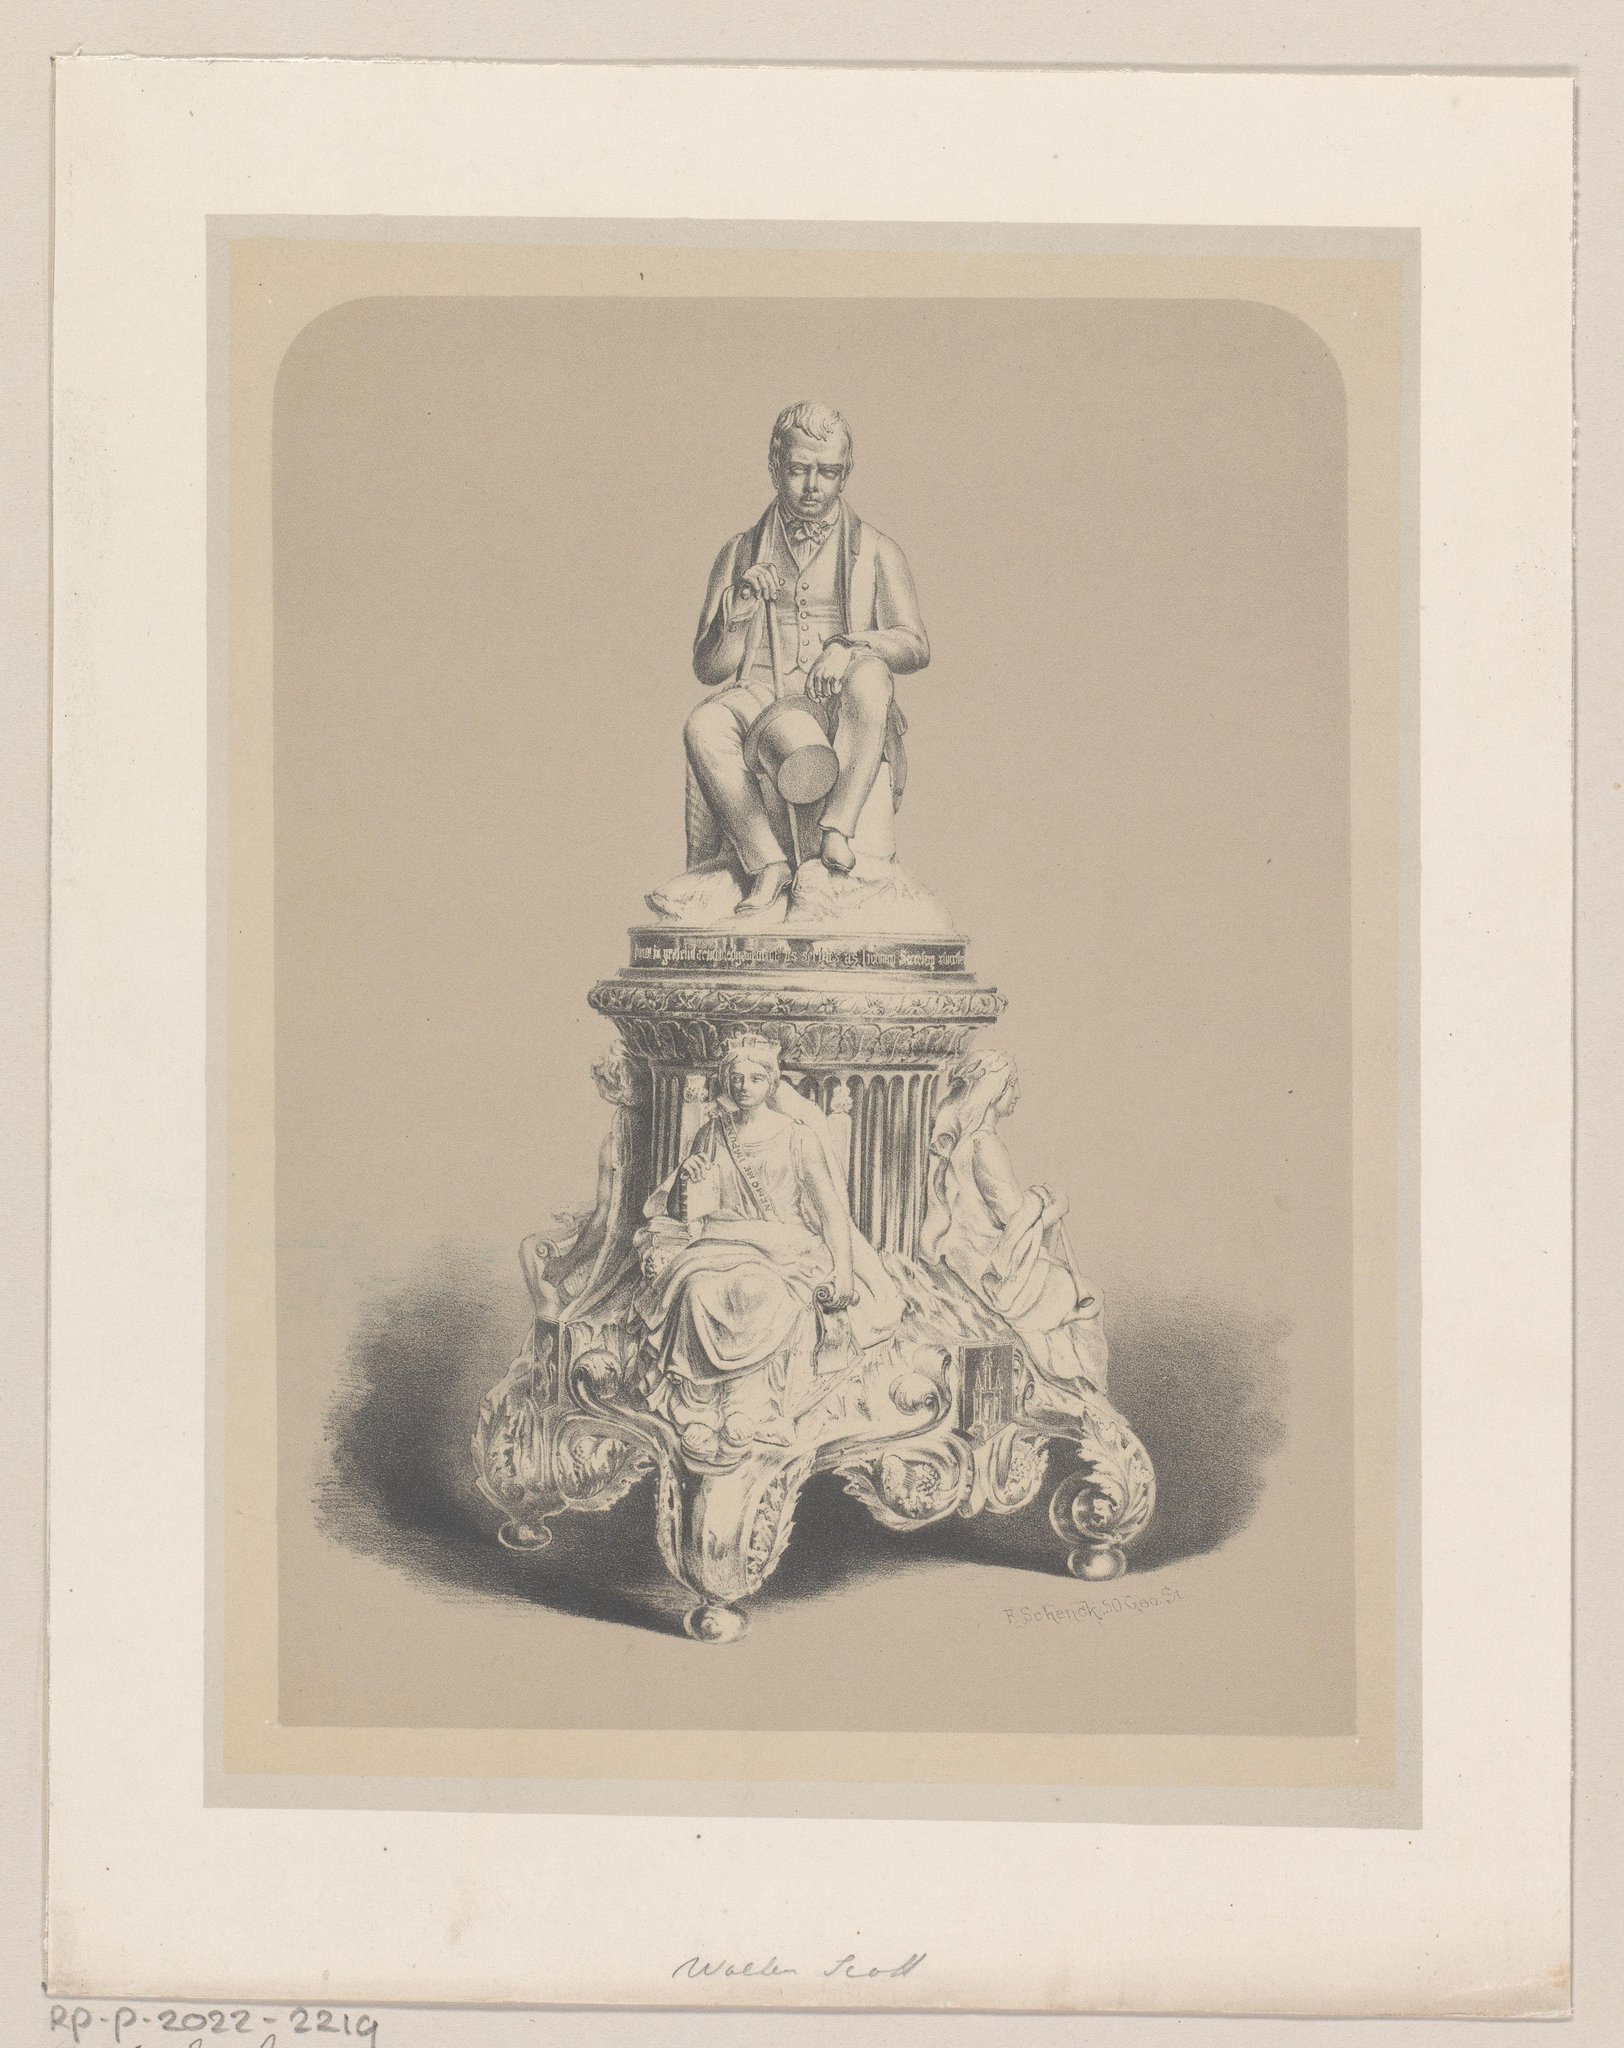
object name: print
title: Sculptuur van Walter Scott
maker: Anonymous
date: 1832-1899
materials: paper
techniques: tone lithography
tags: walter scott, historical persons, portrait of a writer, monument, statue, writer, poet, author